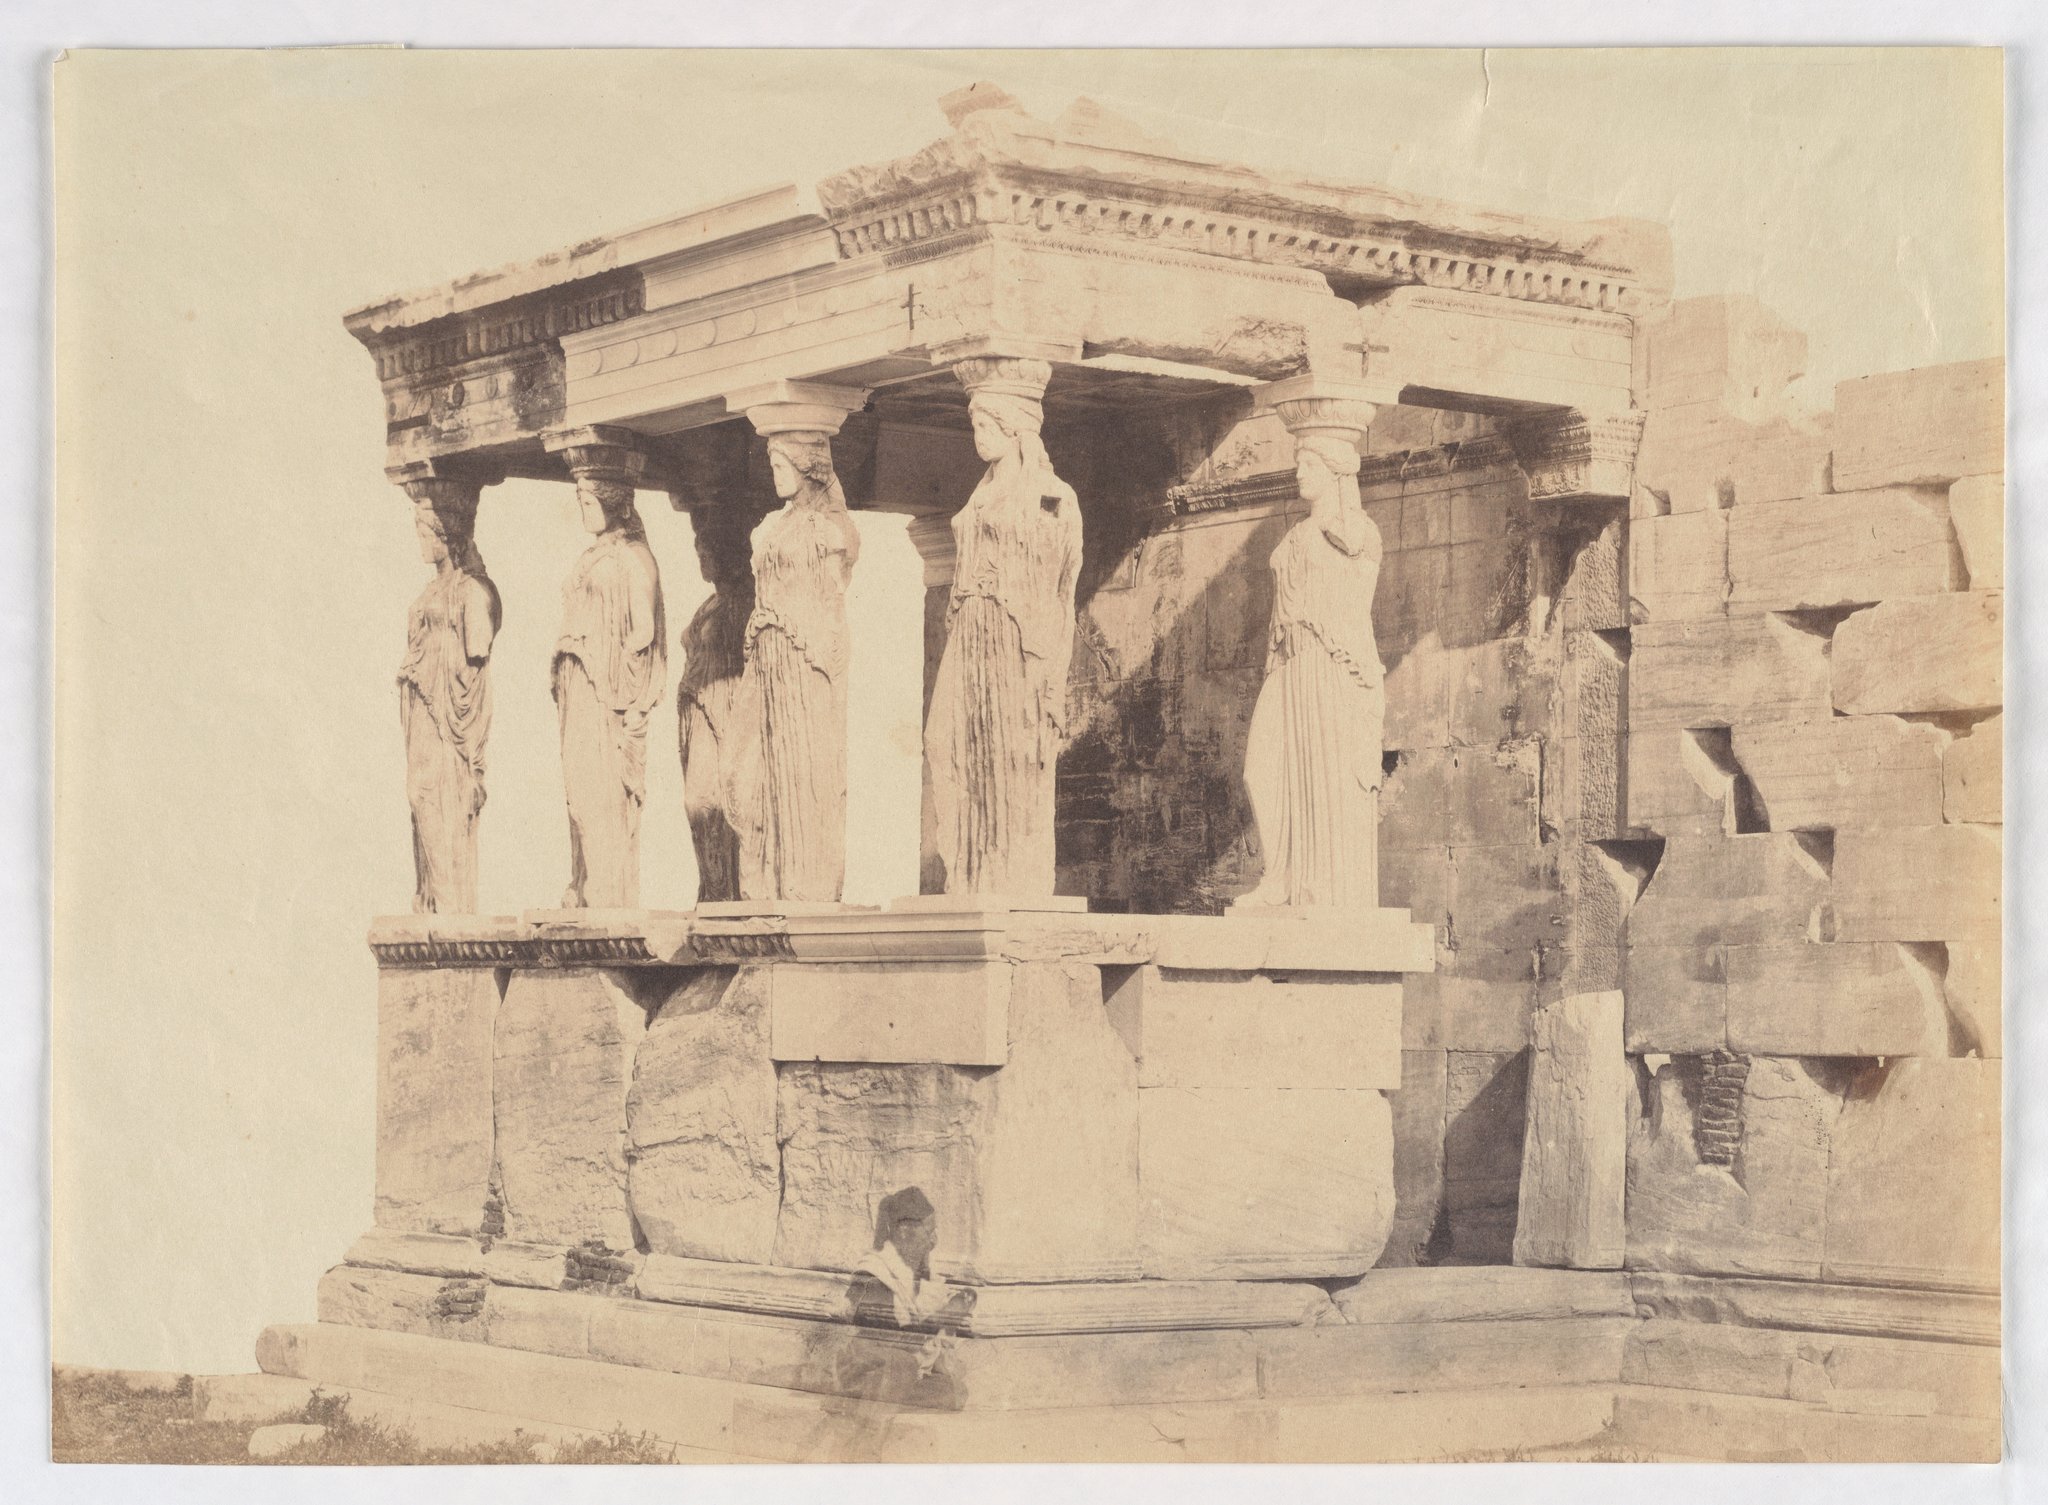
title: [Acropolis, Athens, Greece]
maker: james robertson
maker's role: artist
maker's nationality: british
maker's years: 1813-1881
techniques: salted paper print